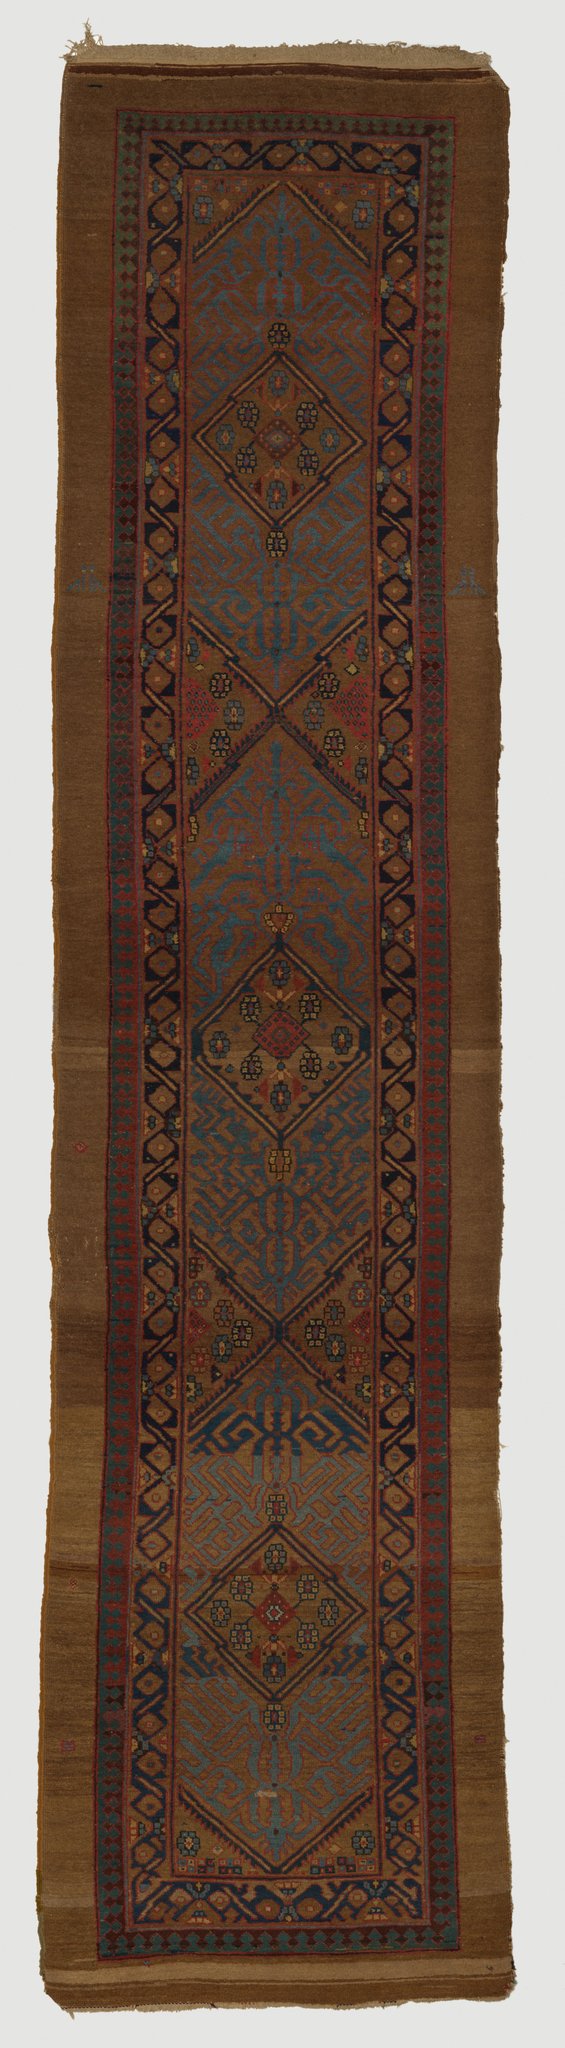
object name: oriental rug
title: Oosters tapijt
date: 1850-1900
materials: wool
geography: hamadan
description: Oosters tapijt van geknoopte wol, loperformaat. Op het middenveld staan drie puntige medaillons met ruitfiguren. Rondom drie randen.